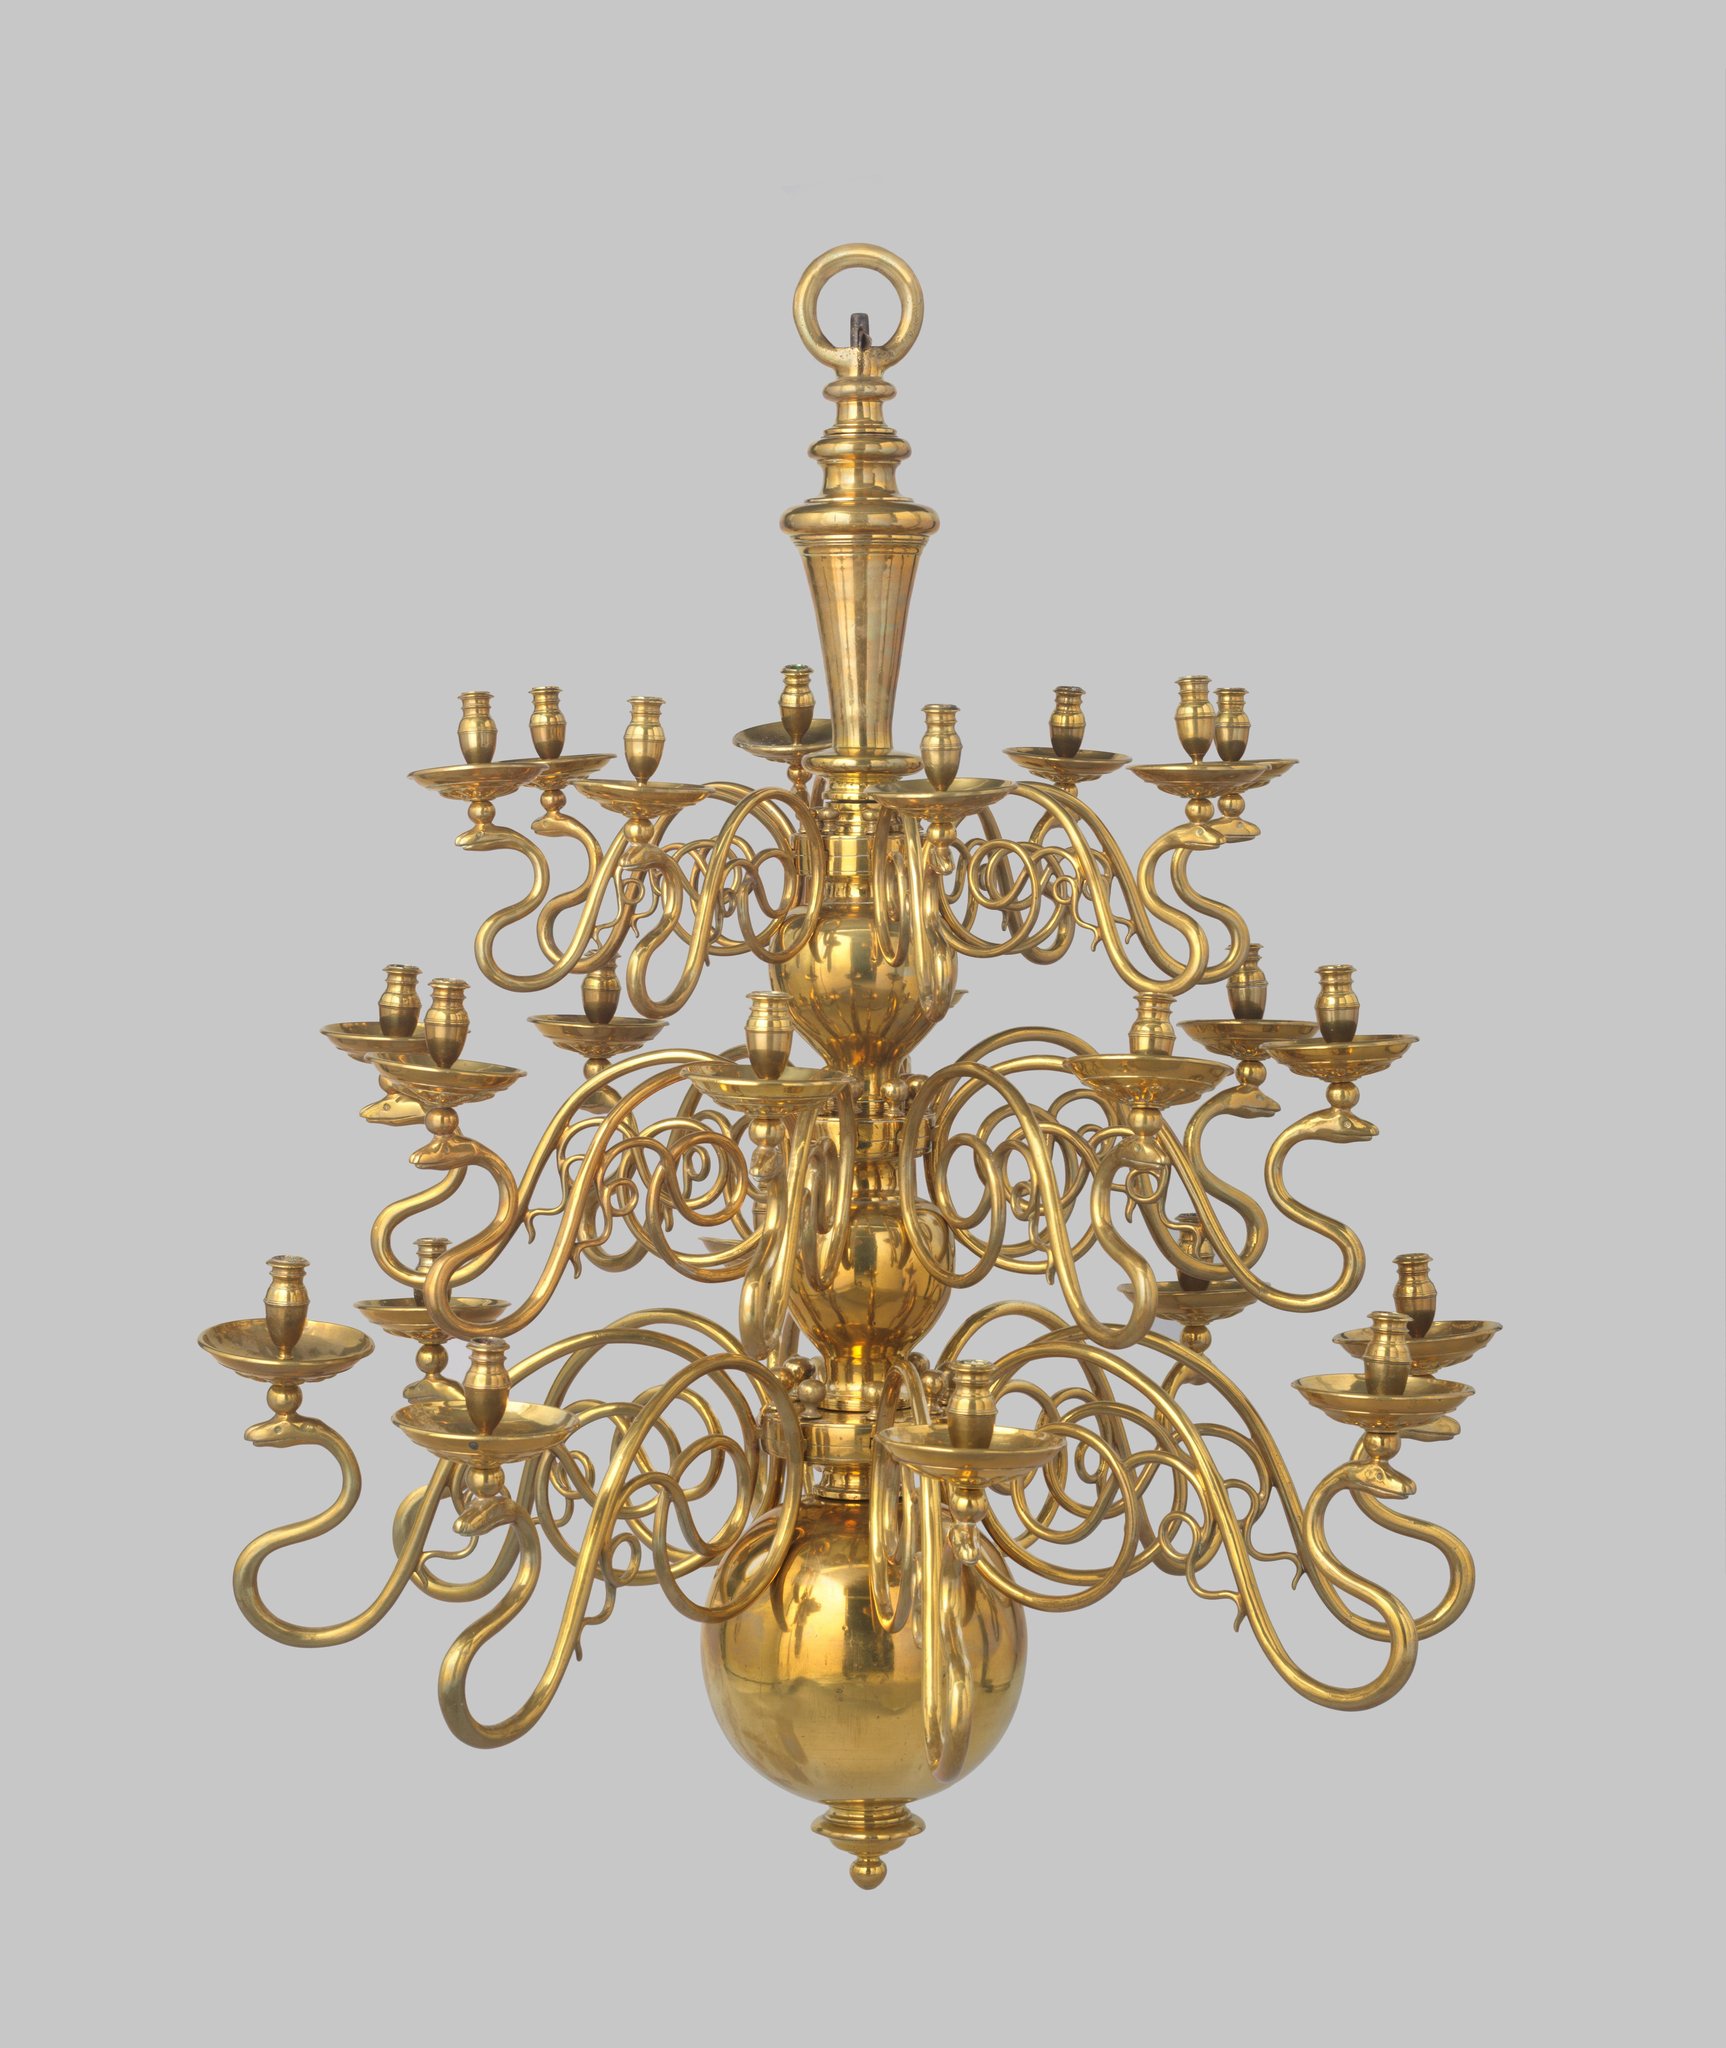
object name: chandelier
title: Arm van een kaarsenkroon in drie hoogten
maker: Anonymous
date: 1625-1650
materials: brass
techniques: screwed, turning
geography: northern netherlands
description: De arm is aan de stamzijde voorzien van een nok, waarin een gat is aangebracht om ze met een pin in de standringen te kunnen vastzetten. De S-vormige arm heeft de gedaante van een slang met een naar de stamzijde gekronkelde staart en naar buiten toe een opgeheven kop met daarop een ronde knop, waarin het van een schroefdraad voorziene gat is aangebracht ter bevestiging van de kaarsenhouders met de vetvangers. De arm is met behulp van hetzelfde model gegoten als de overige armen van de krans. De ronde kaarsenhouder is vaasvormig met een geprofileerde rib. Bovenaan heeft zij twee holronde profileringen, en een uitkragende rand en onderaan een uit twee holronde profileringen bestaande voet. De voet loopt uit in een zich verjongend schroefeind met een centergat. De bolle vetvanger is aan de bovenkant glad en heeft aan de onderkant visblaasachtige godrons en een rib. De vetvanger is met behulp van hetzelfde model gegoten als de overige vetvangers van de krans. De pinnen zijn met bolle knoppen versierd. Dit is de zesde arm van de middelste standring, genummerd op de nok met het cijfer VI.